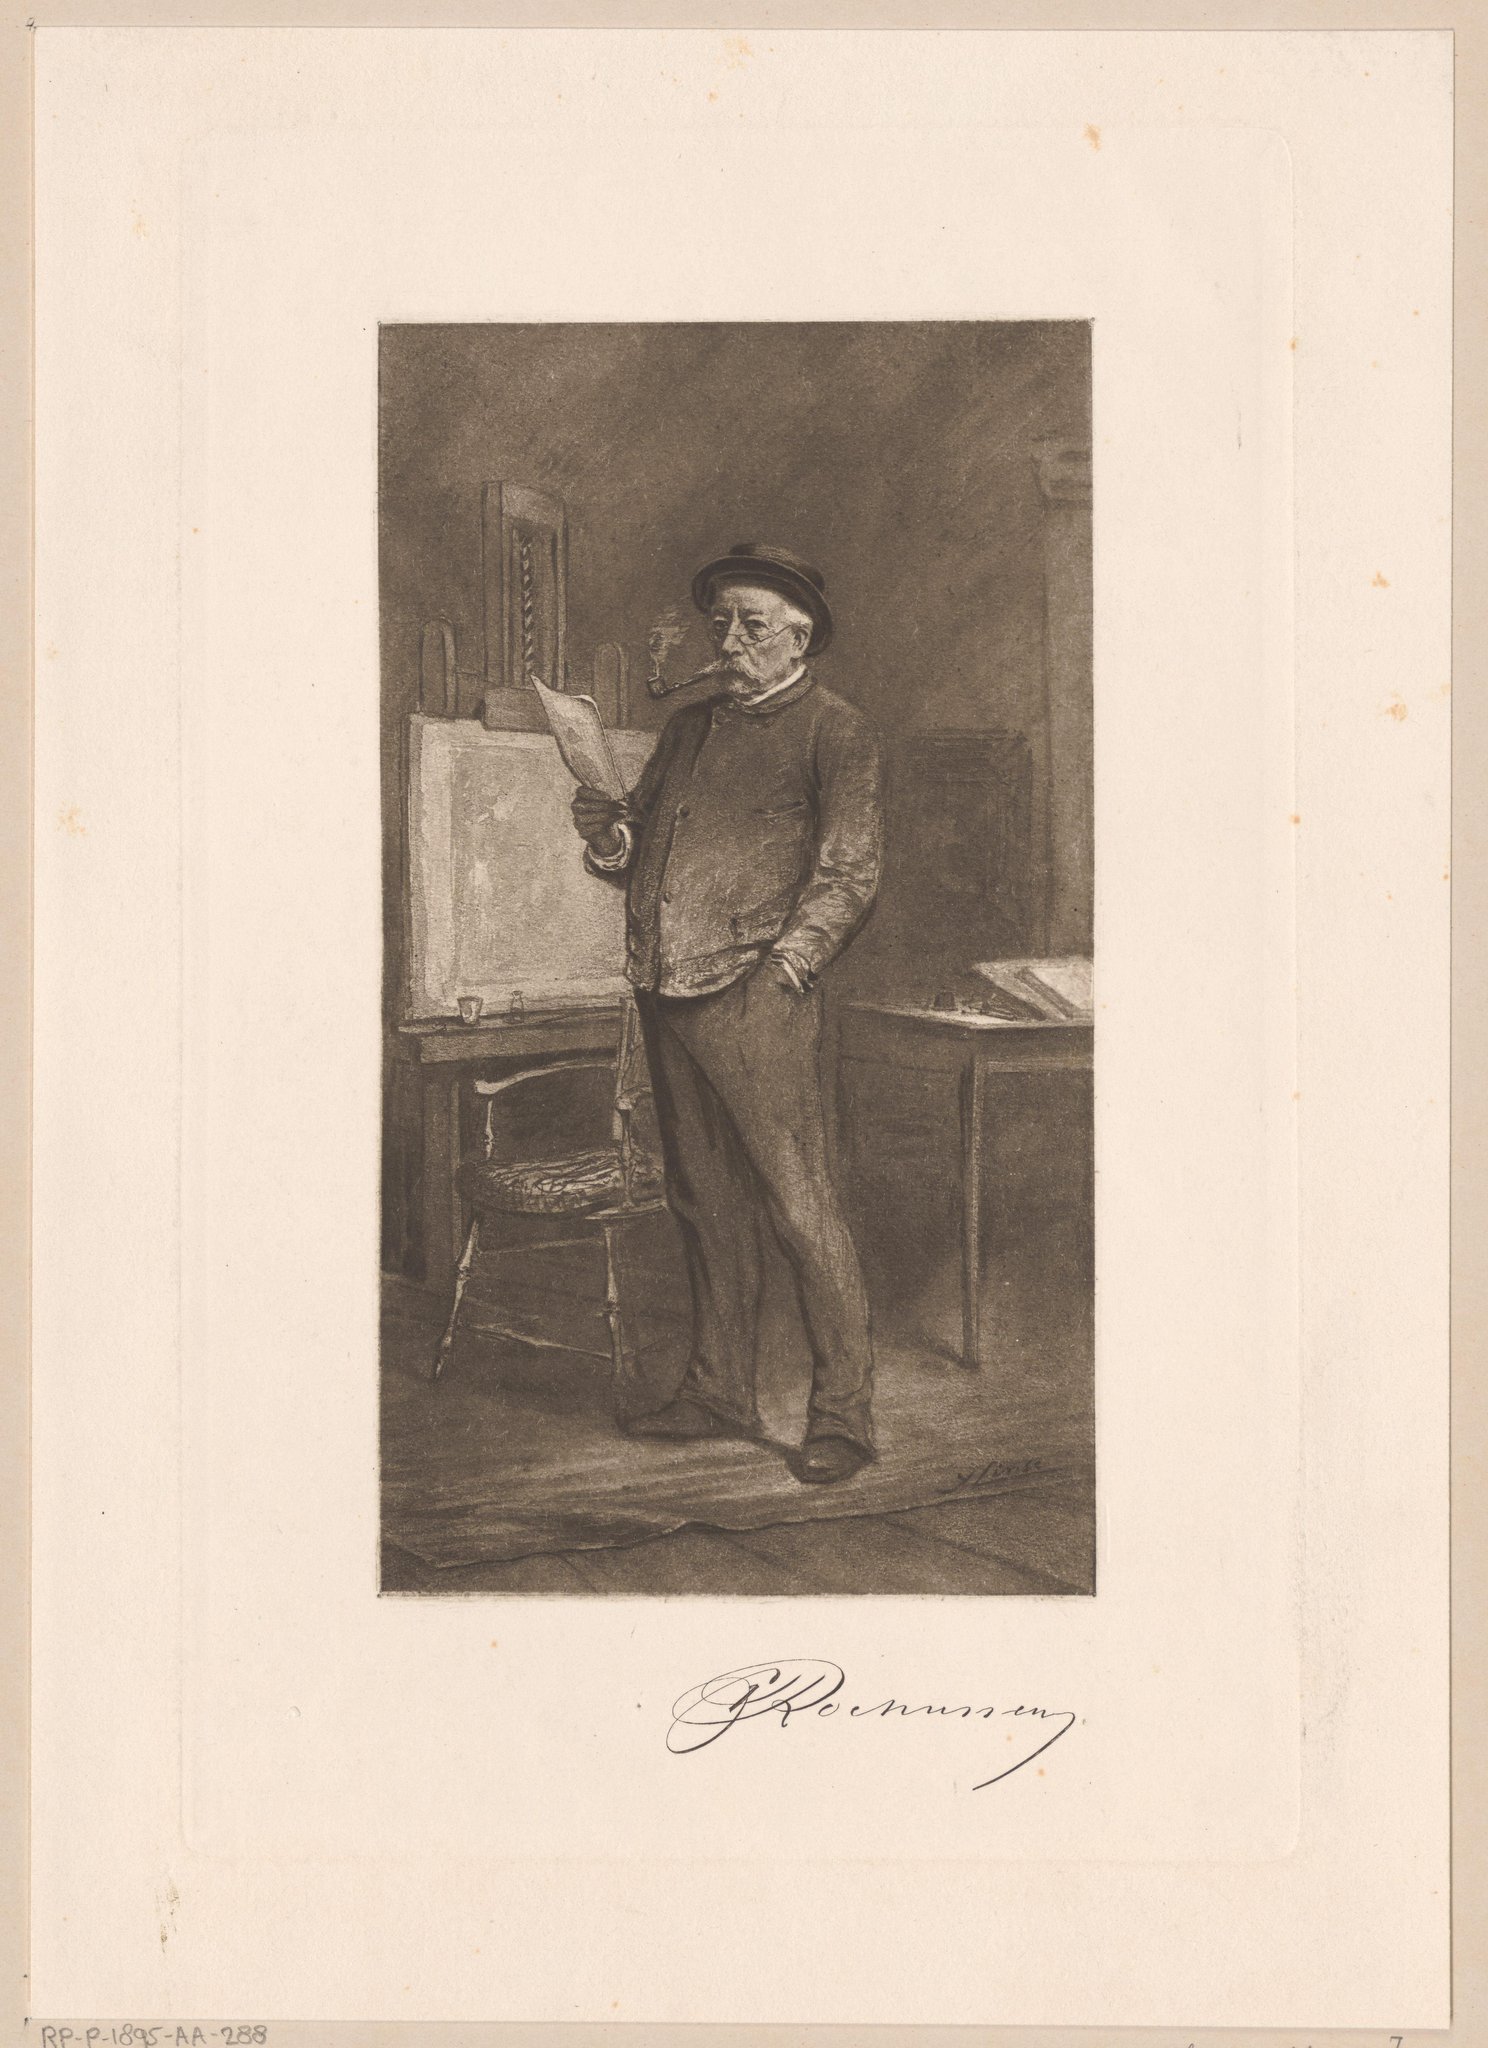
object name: photomechanical print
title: Portret van Charles Rochussen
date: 1875-1895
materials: paper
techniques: photoaquatint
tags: rotterdam, print maker, draughtsman, charles rochussen, historical persons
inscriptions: collector's mark: Lugt 2228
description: Onder het portret een facsimile van de handtekening van de geportretteerde.